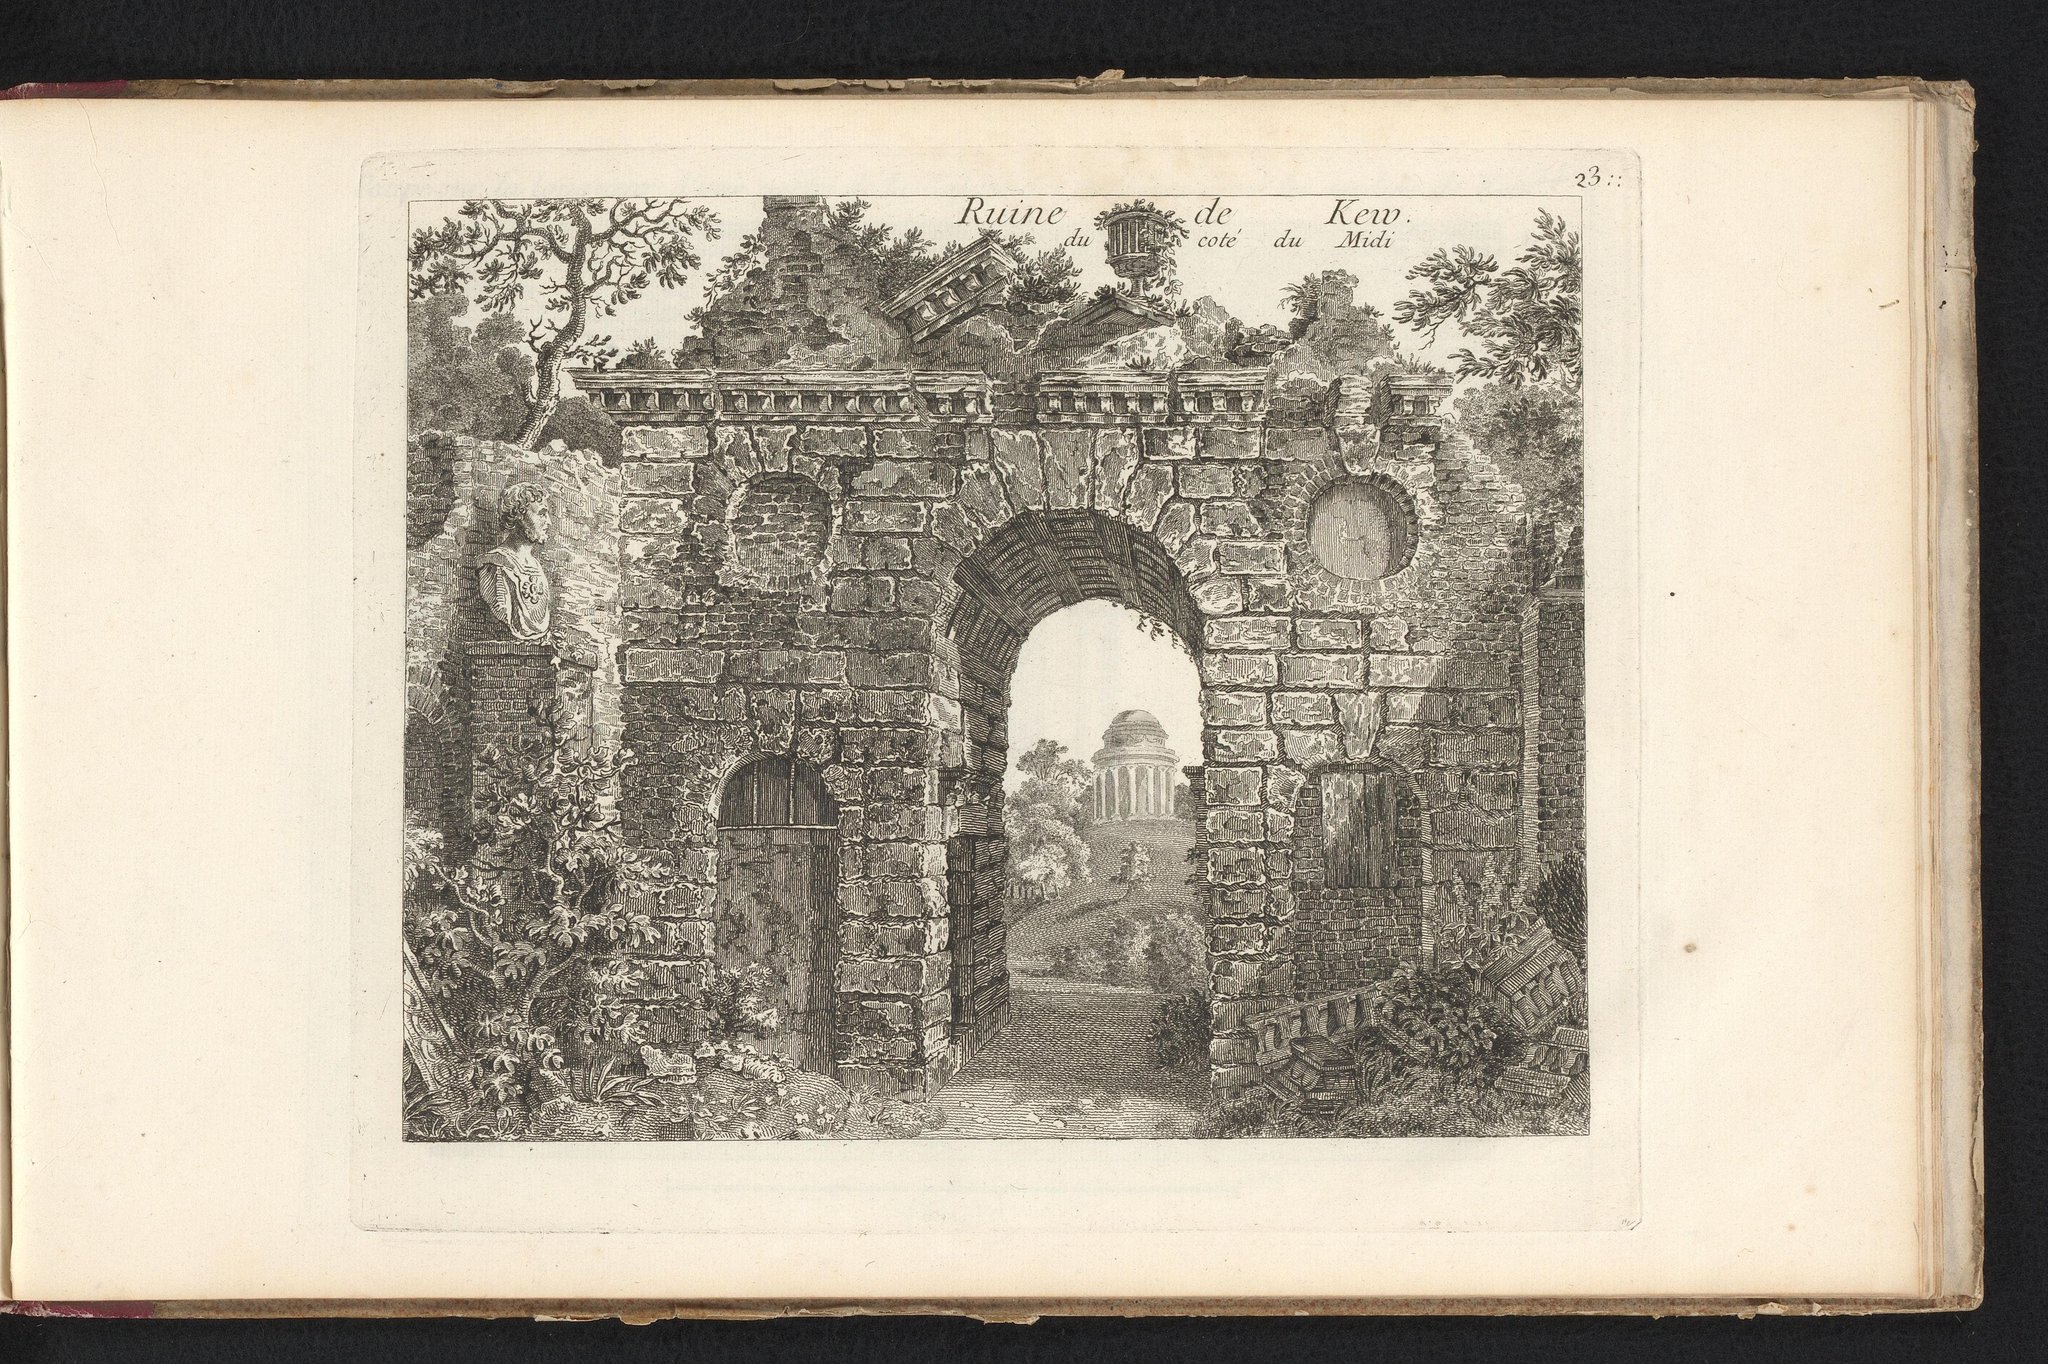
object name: album leaf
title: Landschapstuinen in Chinees-Engelse stijl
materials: paper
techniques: engraving, etching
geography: paris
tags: ruins (garden ornaments)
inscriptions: collector's mark: Lugt 2760, collector's mark: Lugt 2228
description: De serie 'Jardins anglo-chinois à la mode' verscheen in totaal in 21 zogeheten 'cahiers' (afleveringen). De huidige prent komt uit het vierde 'cahier'. Het Rijksmuseum Amsterdam bezit drie banden met daarin in totaal zes 'cahiers' van deze reeks. In de documentatie wordt verwezen naar een in de bibliotheek van het Rijksmuseum Amsterdam aanwezige facsimile van het complete werk.